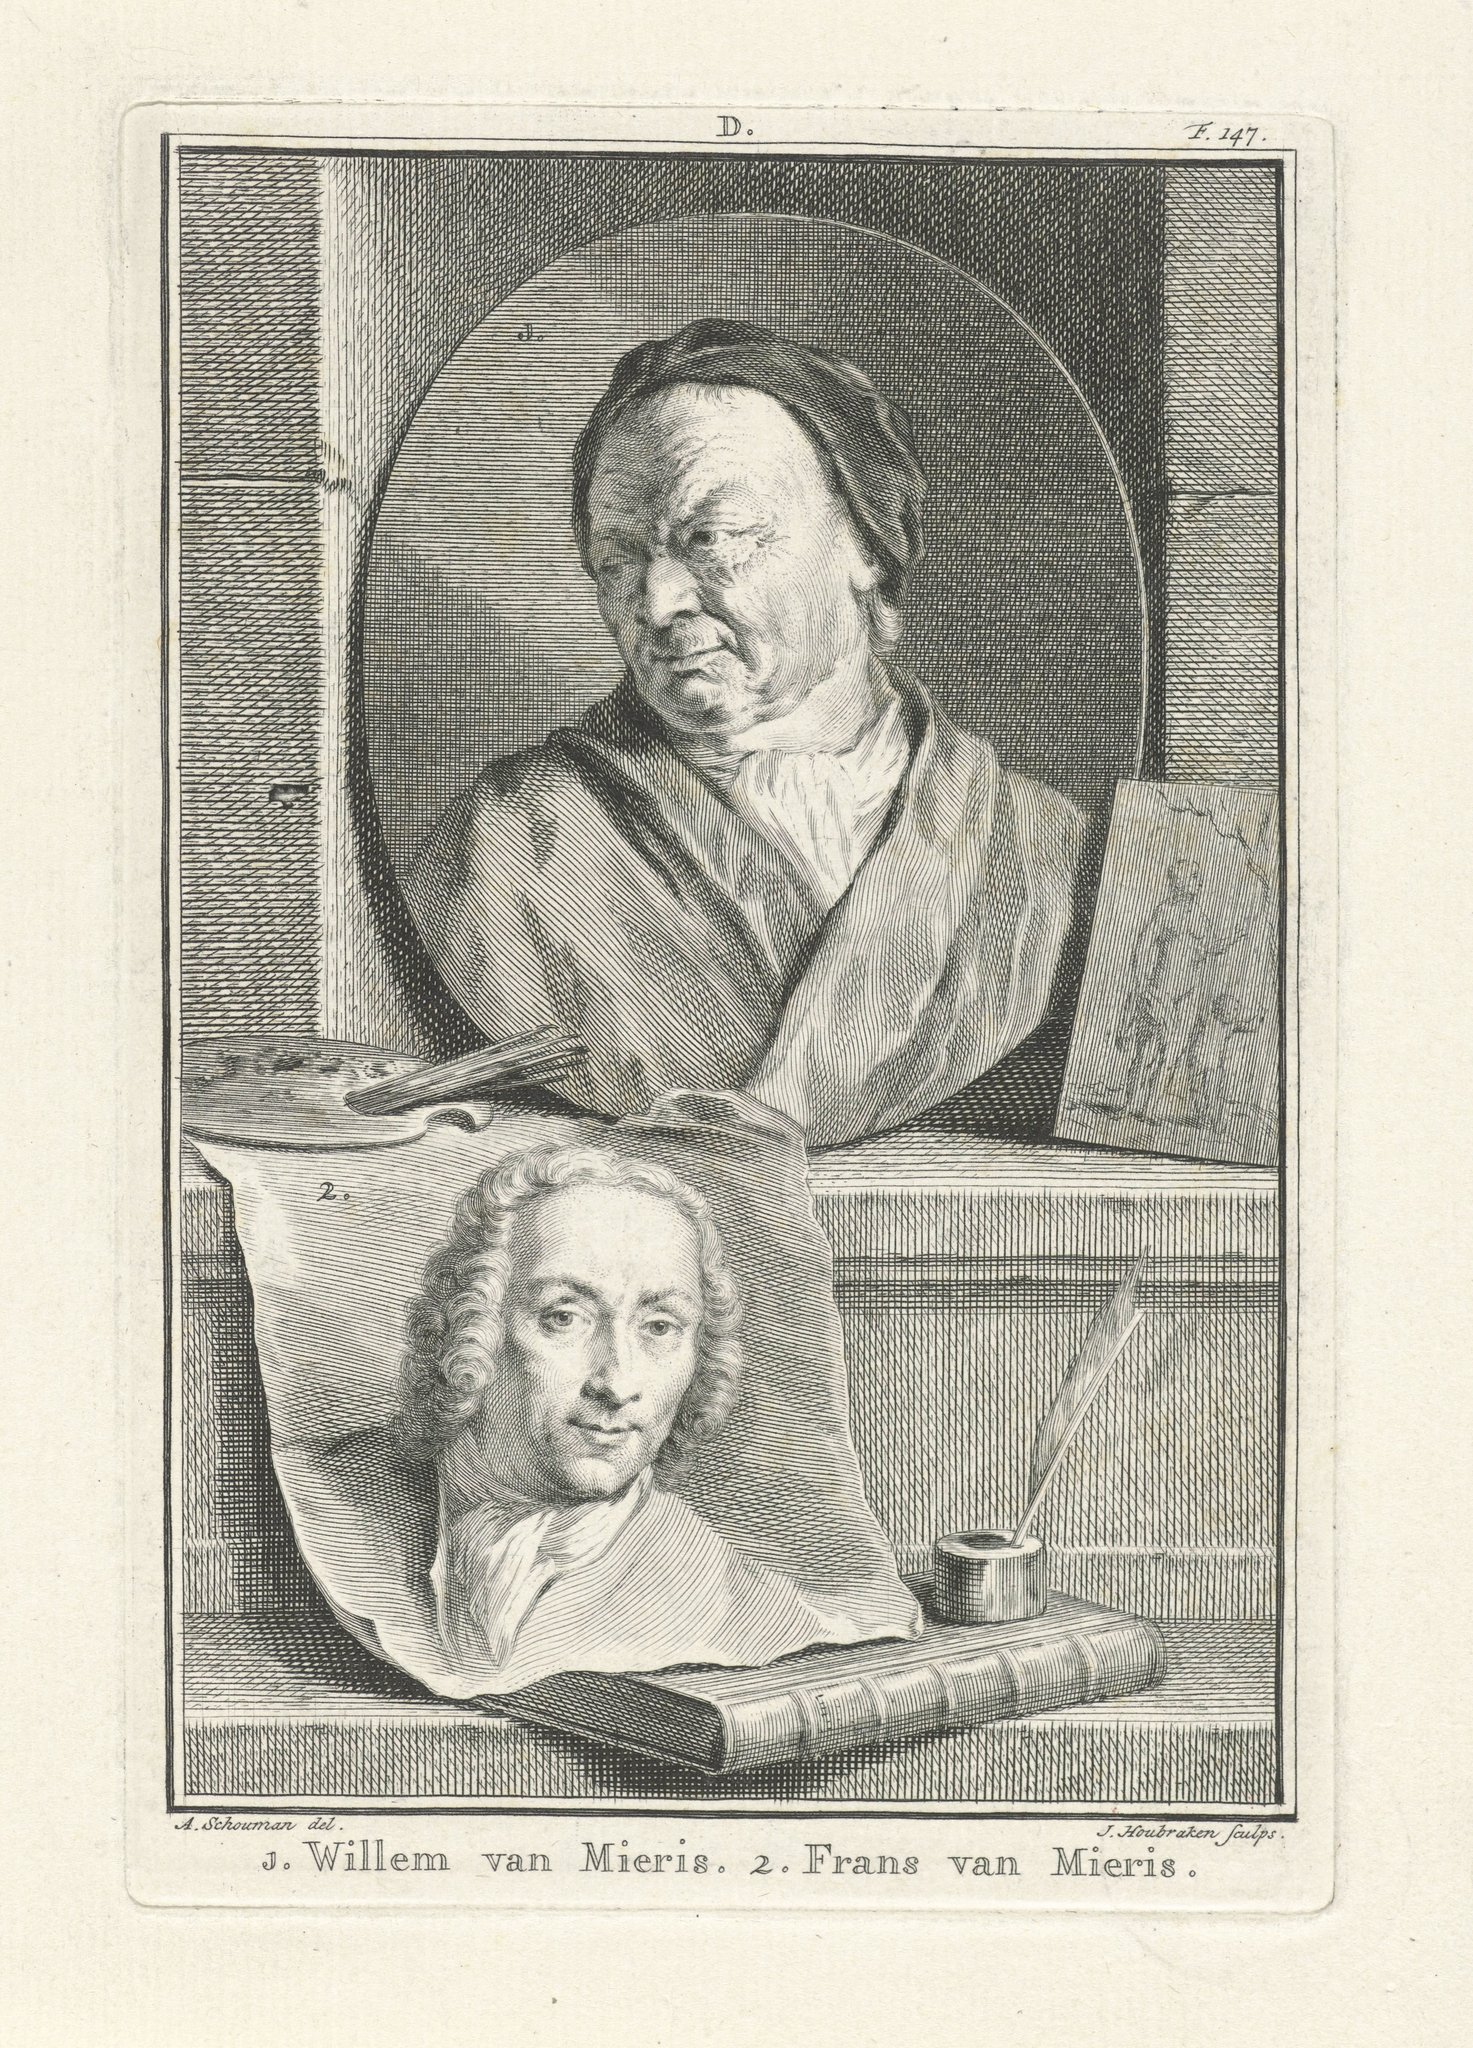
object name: book illustration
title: Portret van Willem en Frans van Mieris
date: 1751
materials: paper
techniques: engraving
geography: amsterdam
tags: leiden, painter, print maker, draughtsman, willem van mieris, frans van mieris (ii)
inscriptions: name: ‘JvGool’, collector's mark: Lugt 240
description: Prent ook gebruikt in: Johan van Gool. De nieuwe Schouburg der Nederlantsche kunstschilders en schilderessen : waer in de levens- en kunstbedrijven er tans levende en reets overleedene schilders, die van Houbraken, noch eenig ander schrijver, zijn aengeteekend, verhaelt worden. 2 dl. Den Haag: 1750-1751.